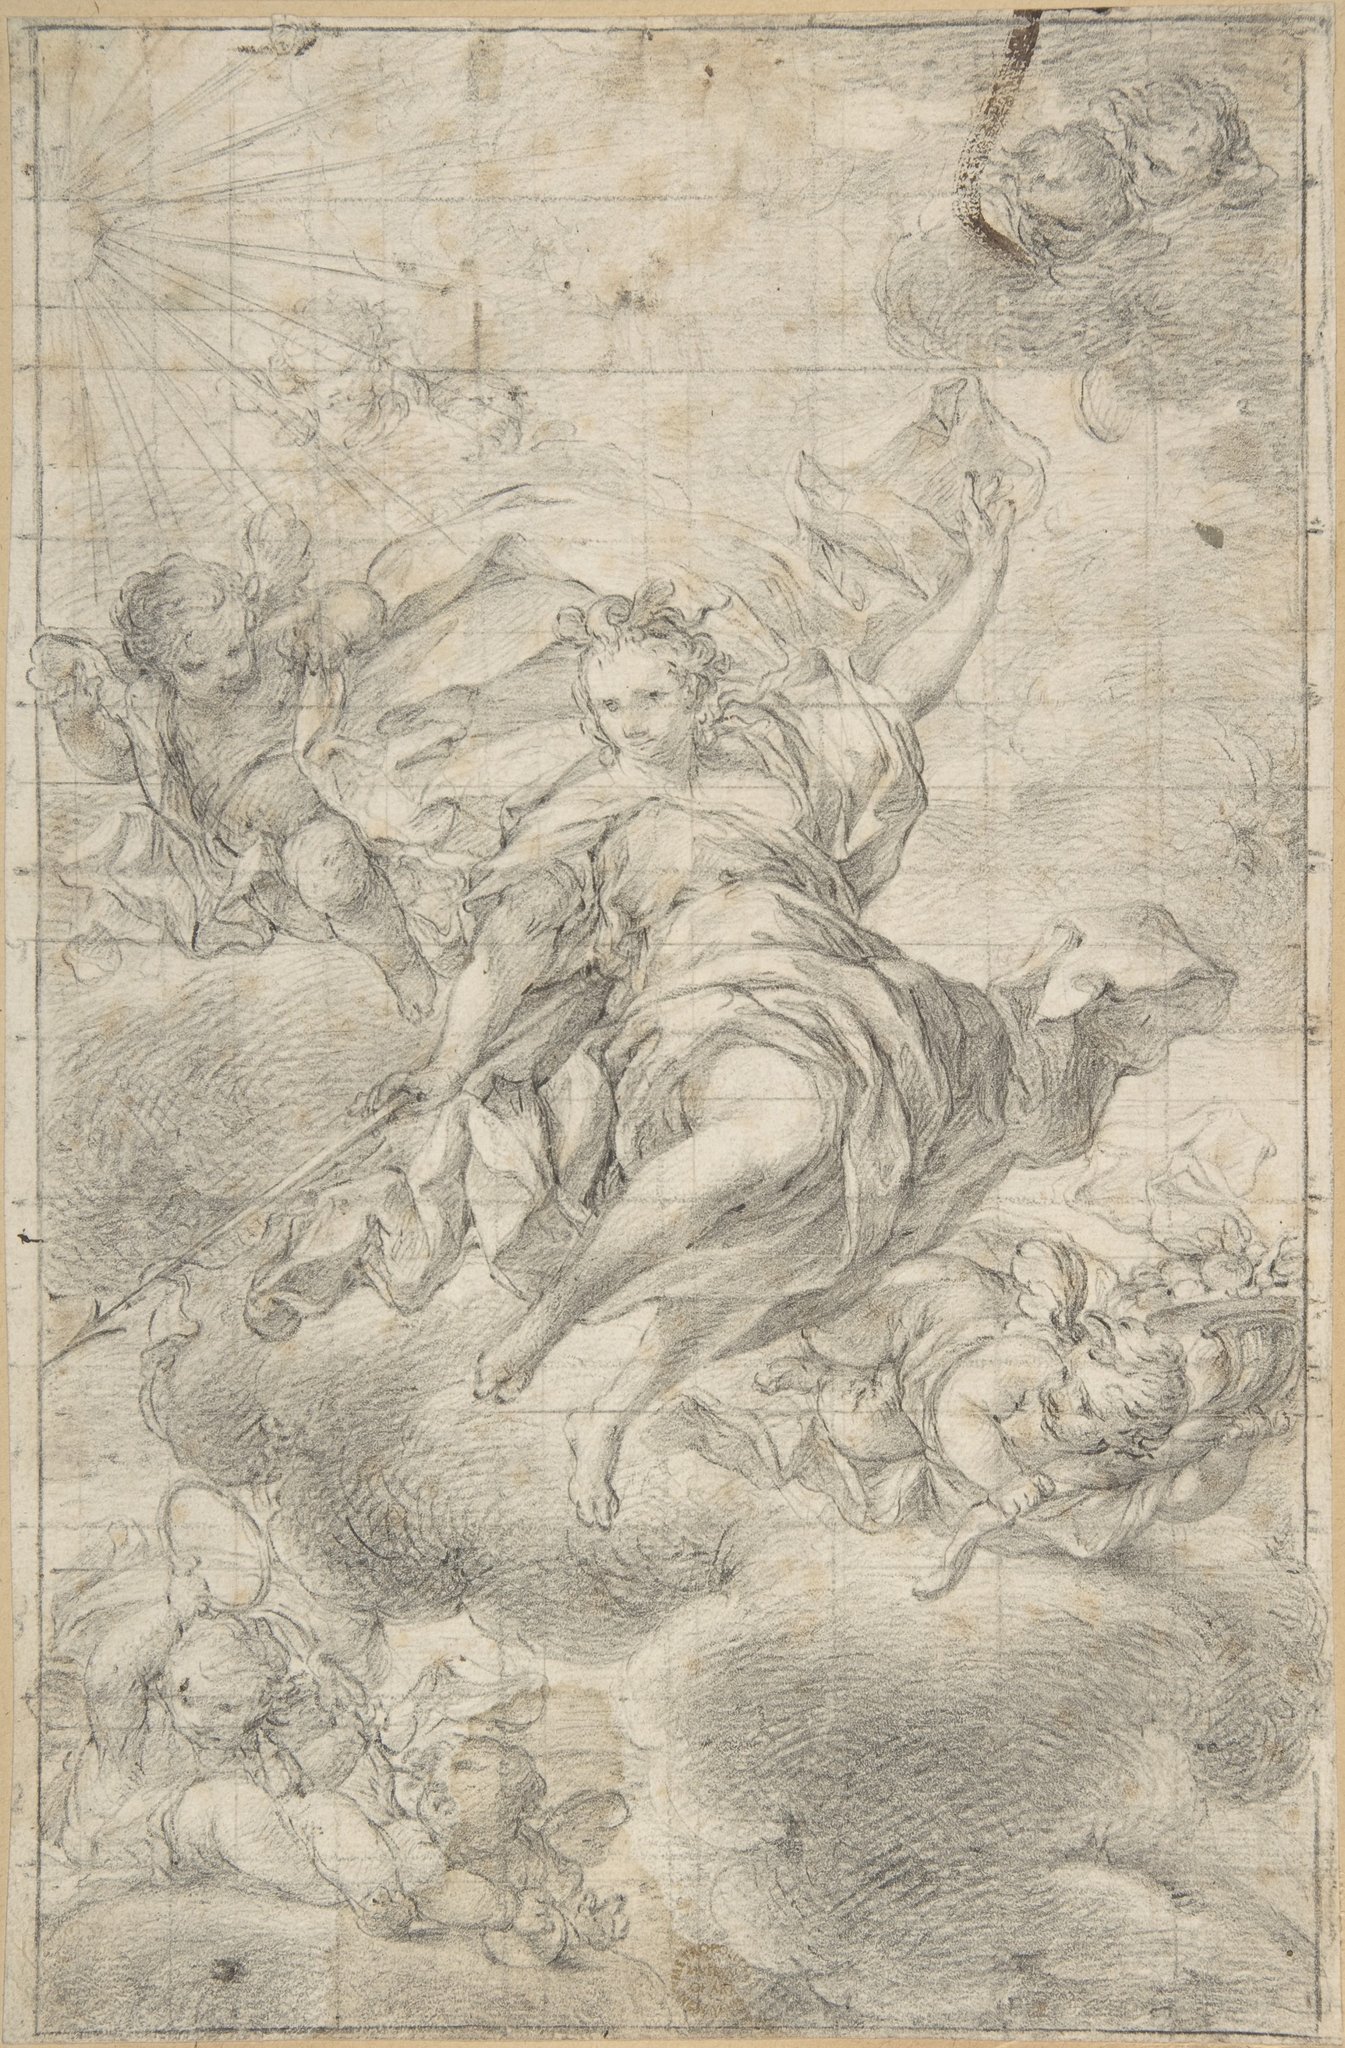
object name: drawing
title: Design for a Ceiling Painting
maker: anonymous, italian, 18th century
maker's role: artist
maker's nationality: italian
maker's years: 1700-1800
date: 1701-1800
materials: chalk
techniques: drawing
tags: women,putti